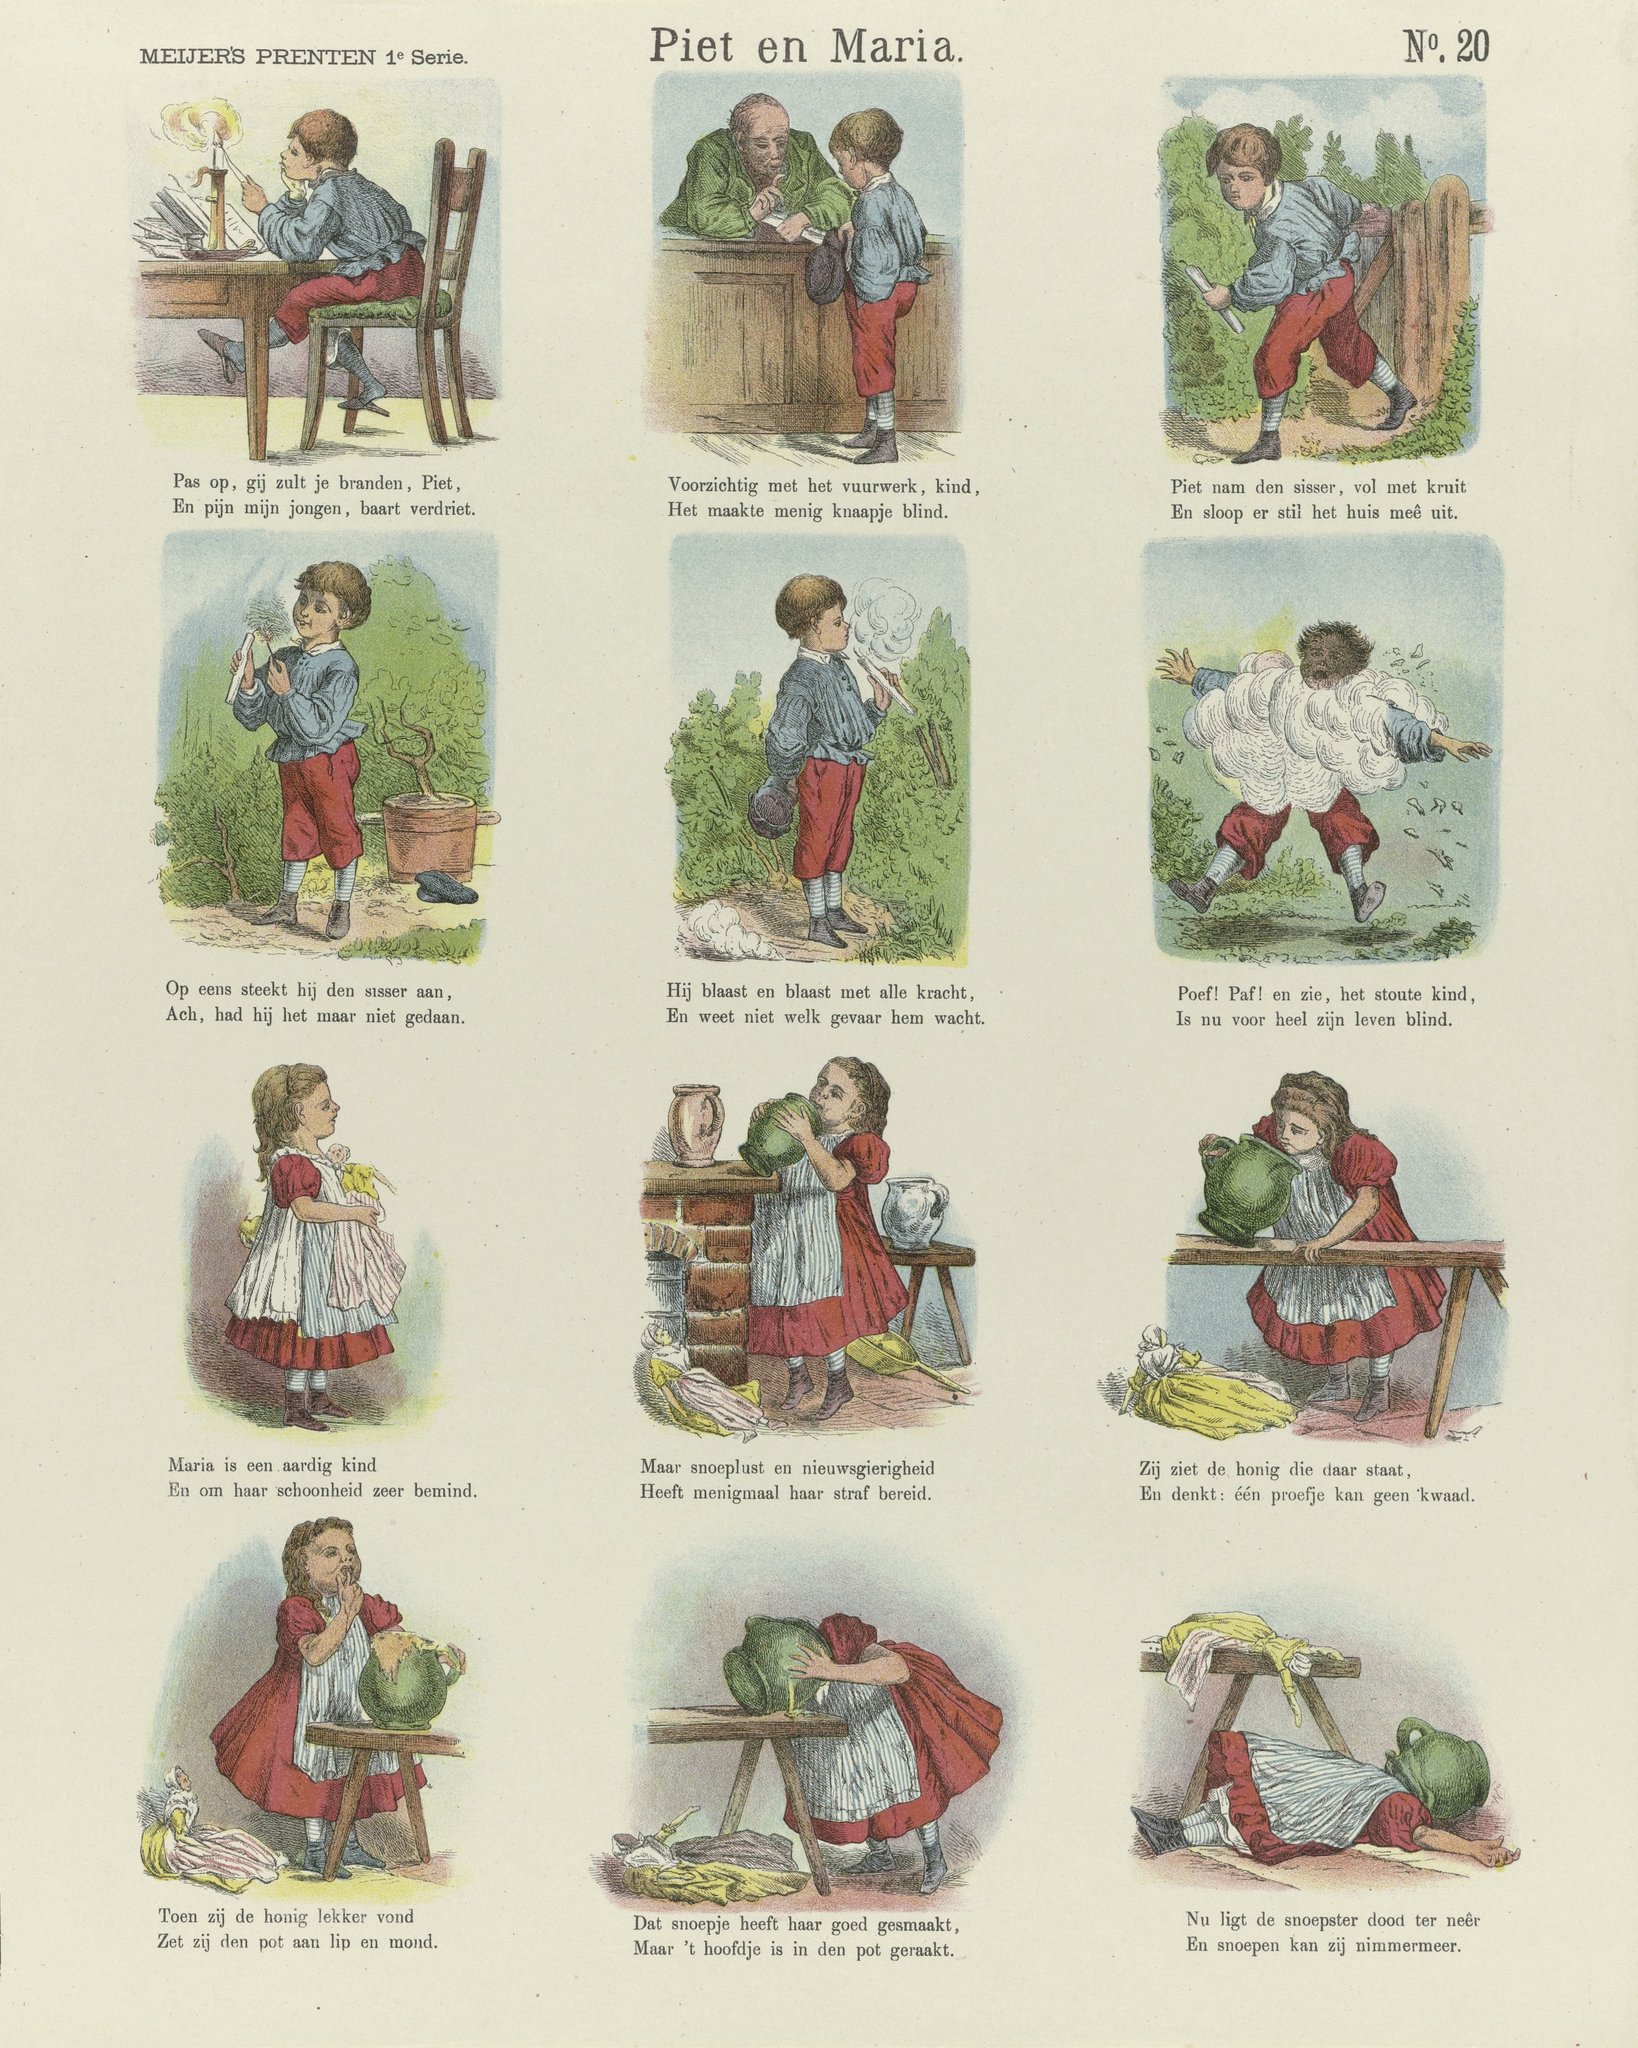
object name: print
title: Piet en Maria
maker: Anonymous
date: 1873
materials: paper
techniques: lithograph, letterpress printing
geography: amsterdam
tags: child, bad behaviour, sugar-candy, bonfire, fire-works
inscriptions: collector's mark: Lugt 2760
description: Blad met 12 voorstellingen over het jongetje Piet en het meisje Maria. Piet wordt blind door spelen met vuurwerk en Maria overlijdt door snoeplust. Onder elke voorstelling een tweeregelig vers. Genummerd rechtsboven: No. 20.